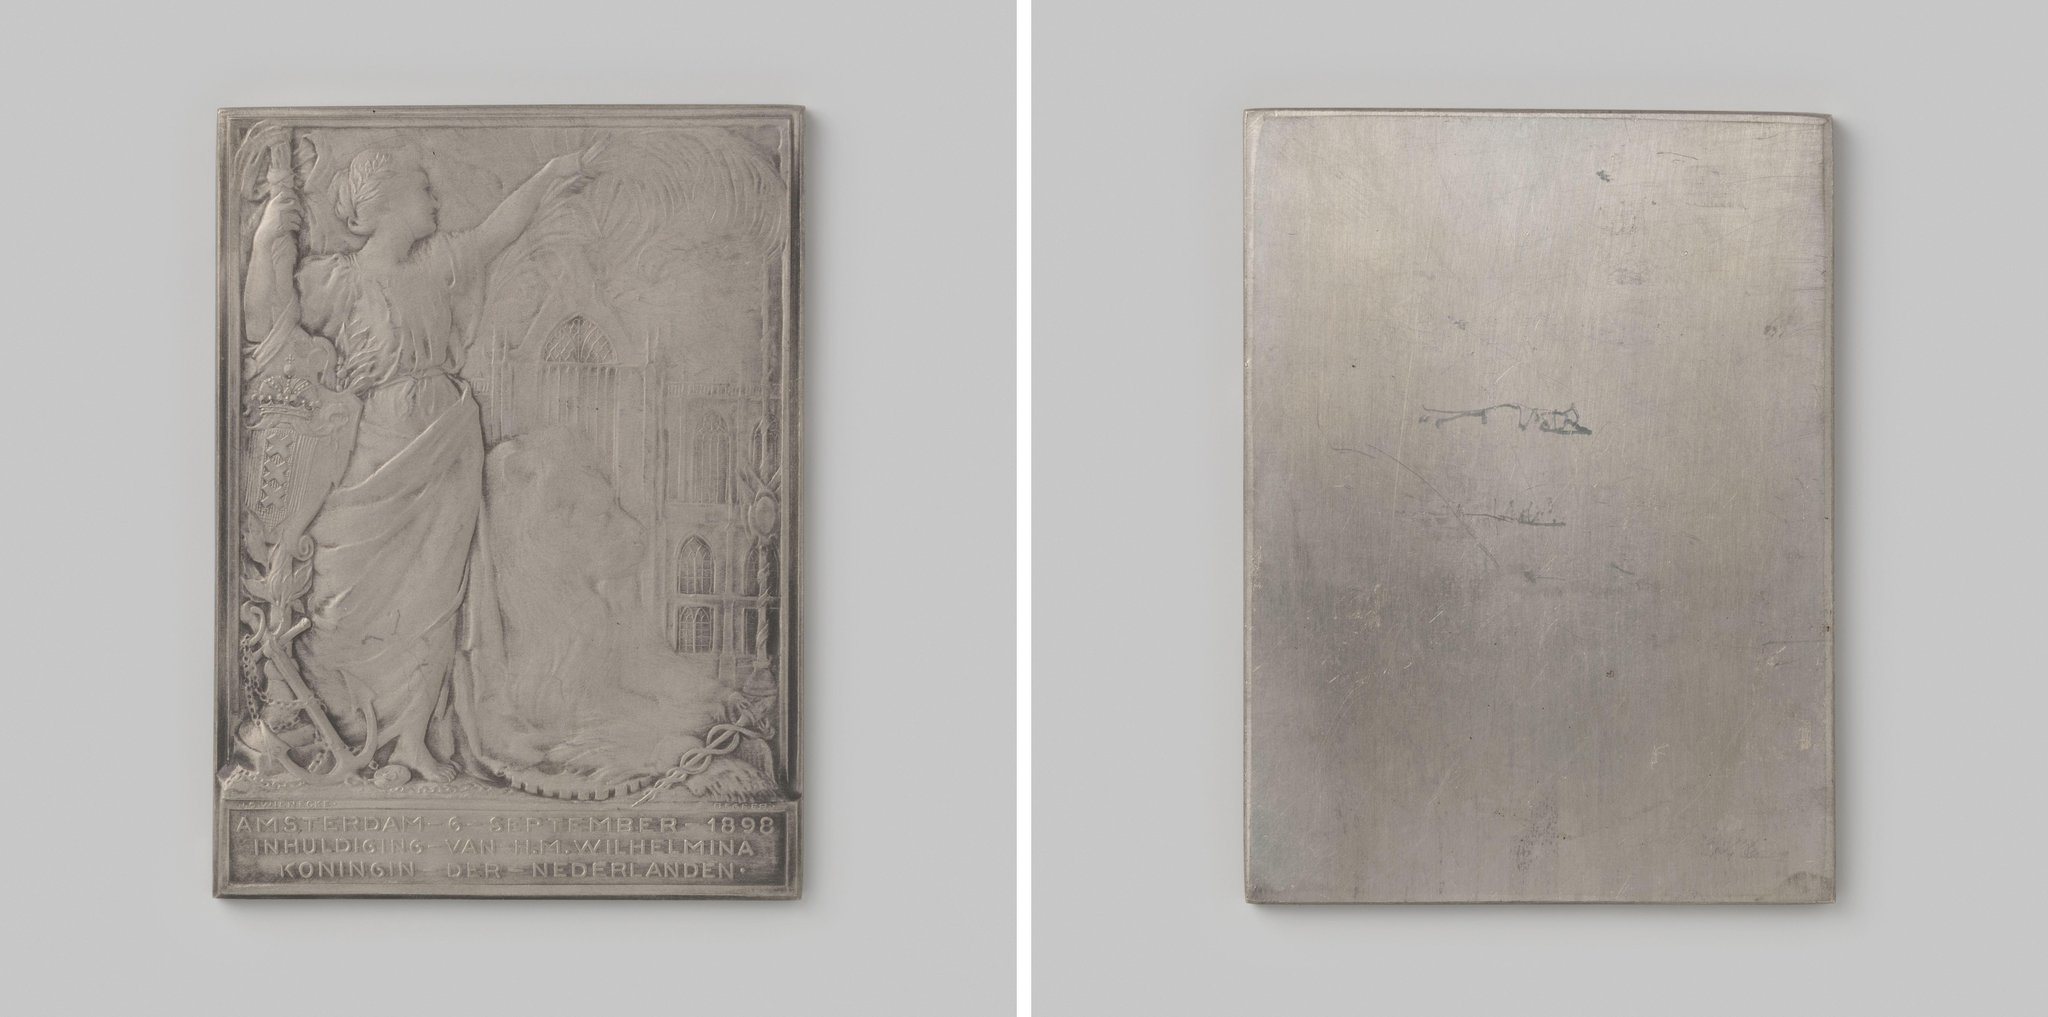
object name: history medal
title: Inhuldiging van Koningin Wilhelmina in de Nieuwe Kerk te Amsterdam 1898 (plaquette)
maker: johannes cornelis wienecke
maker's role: medailleur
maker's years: 1872-1945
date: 1898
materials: silver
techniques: striking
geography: utrecht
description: Rechthoekige eenzijdige zilveren plakette, de Amsterdamse Stedemaagd, leunend tegen een zuil waaraan een Amsterdams wapenschild, met aan haar voeten een leeuw en symbolen van nijverheid en handel, ontsluiert de Nieuwe Kerk, met onderaan een balk met drie regels tekst.